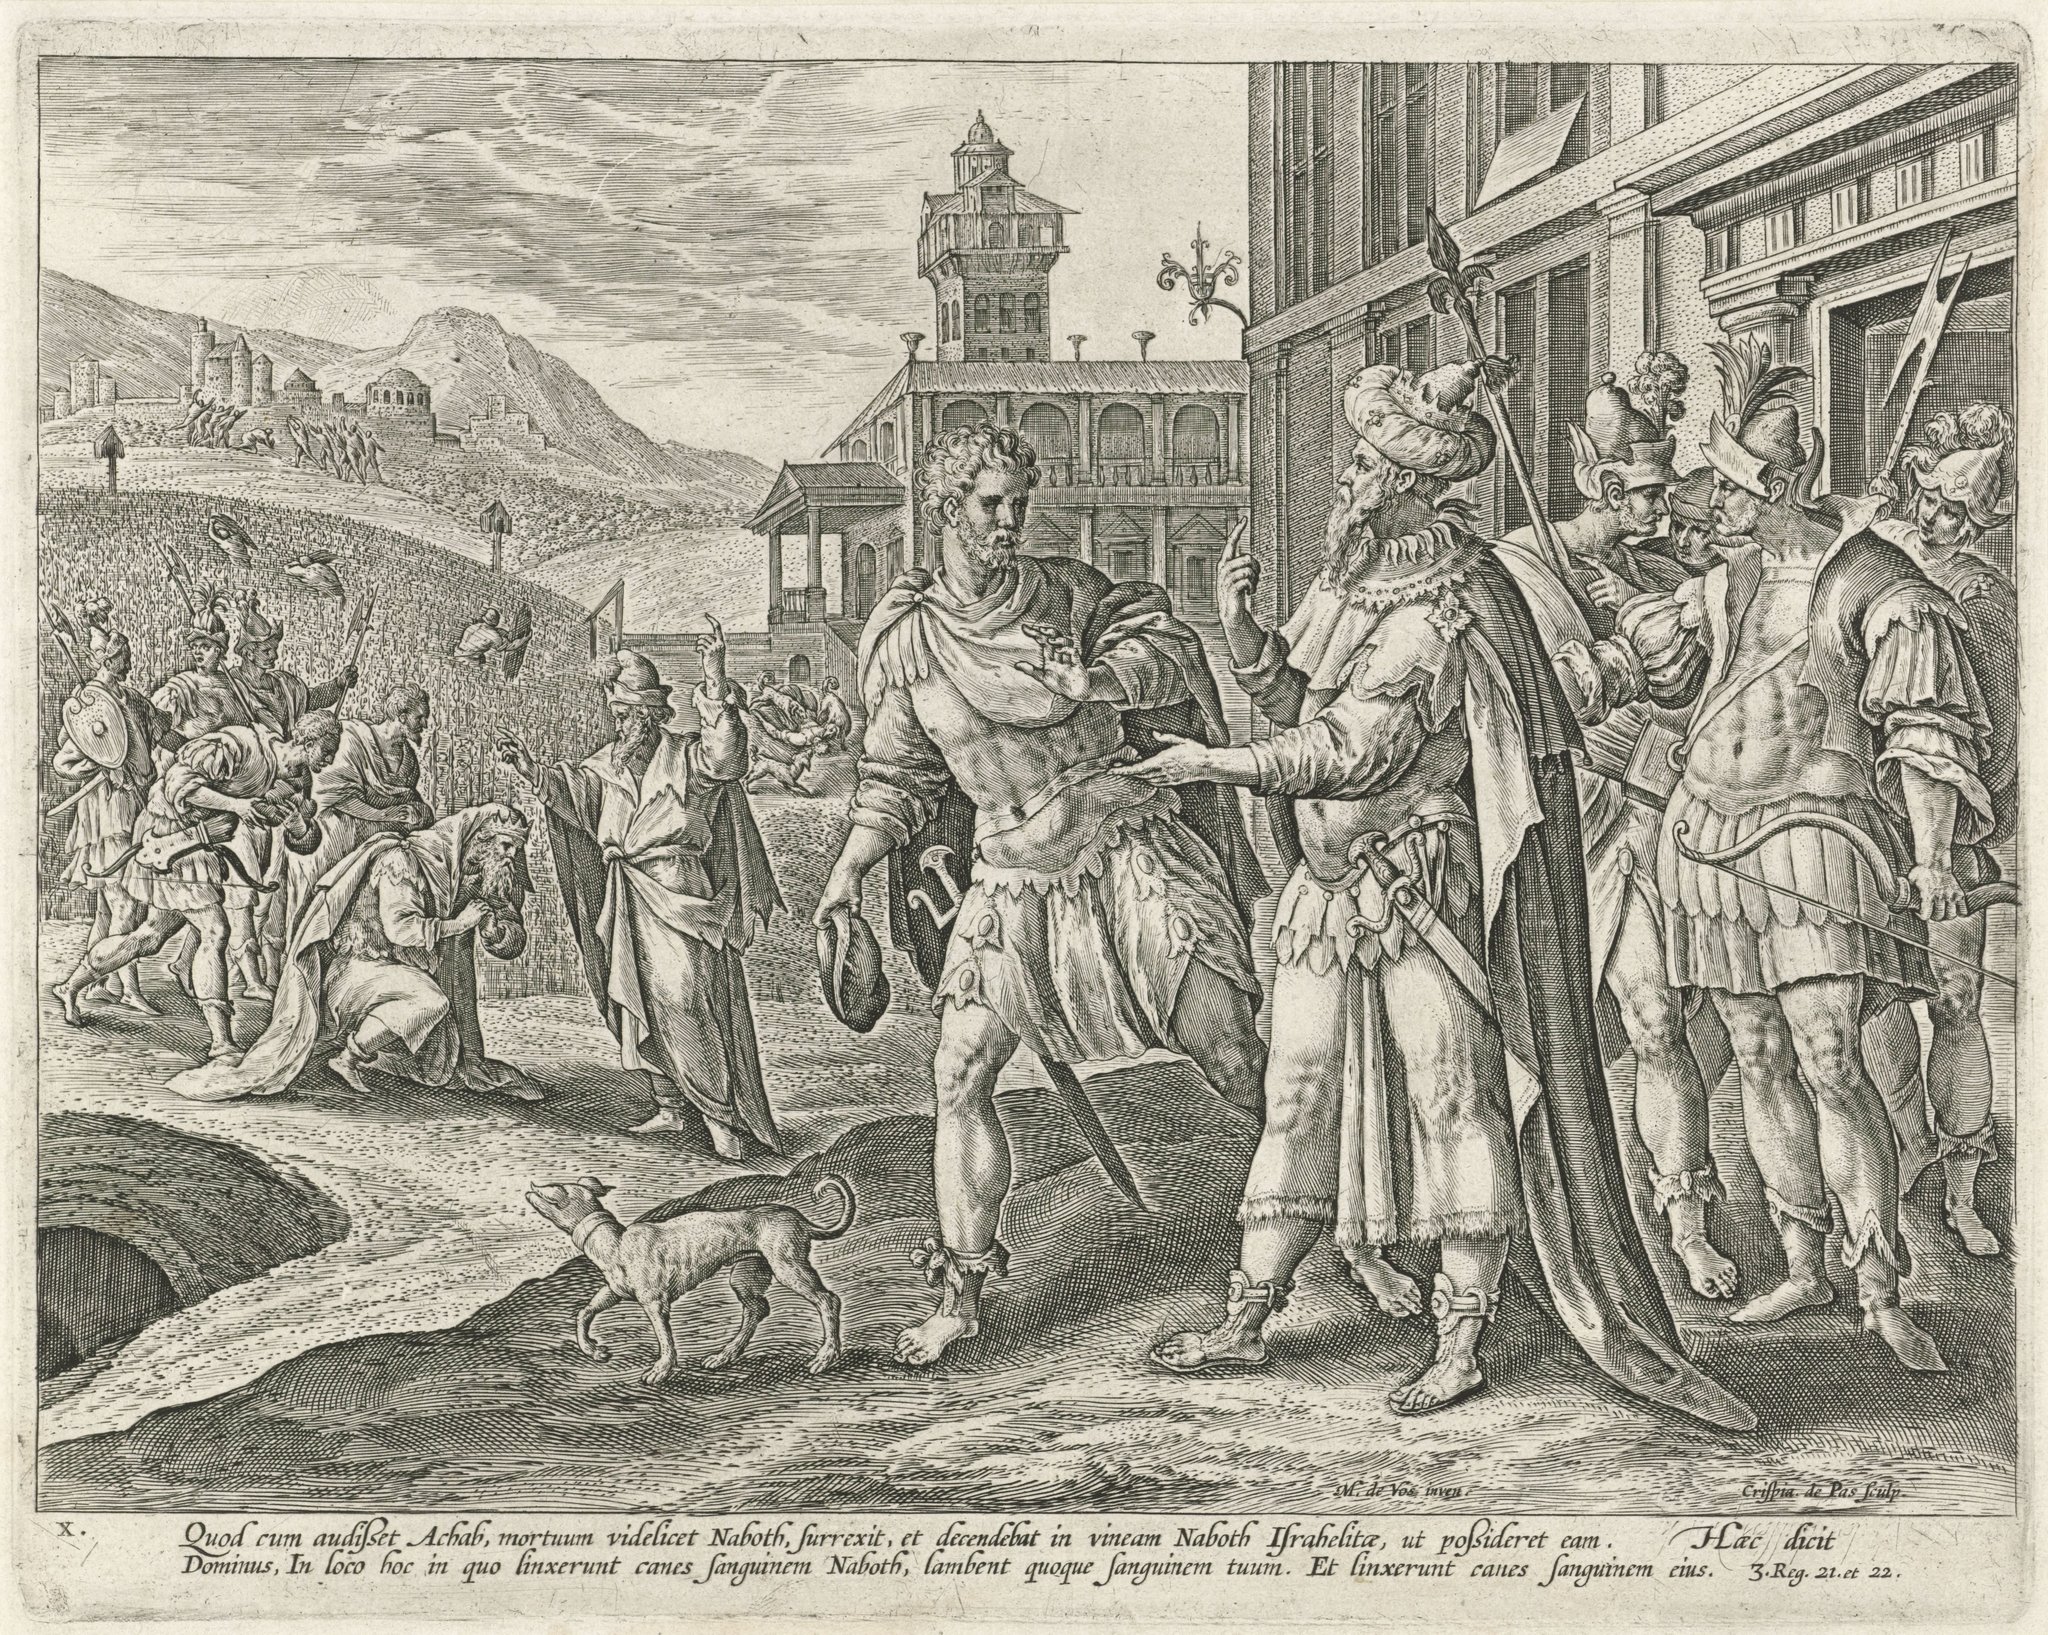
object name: print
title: Tien Geboden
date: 1574-1637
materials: paper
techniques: engraving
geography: antwerp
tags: naboth is stoned to death, naboth refuses to sell his vineyard to ahab, 'you shall not covet' ~ separate representation of the tenth of the ten commandments, ahab's chariot and his armour are washed in the pool of samaria; the dogs lick up his blood, thus fulfilling elijah's prophecy, naboth's vineyard (~ king ahab) (1 kings 21)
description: Koning Achab van Samaria vraagt aan Nabot de prijs voor zijn wijngaard. Nabot wil echter zijn eigendom niet verkopen, waarop Achab hem laat stenigen (1Kon. 21:1-29). Op de achtergrond vertelt de profeet Elia aan Achab dat hij door God gestraft zal worden omdat hij in schending is van het tiende Gebod: "Gij zult niets begeren dat van uw naaste is". Het nageslacht van Achab zal sterven waar ook Nabot is gestorven en verorberd worden door honden. In de marge een tweeregelig onderschrift in het Latijn. De prentserie beeldt de Tien Geboden uit door middel van scènes van het Oude Testament.